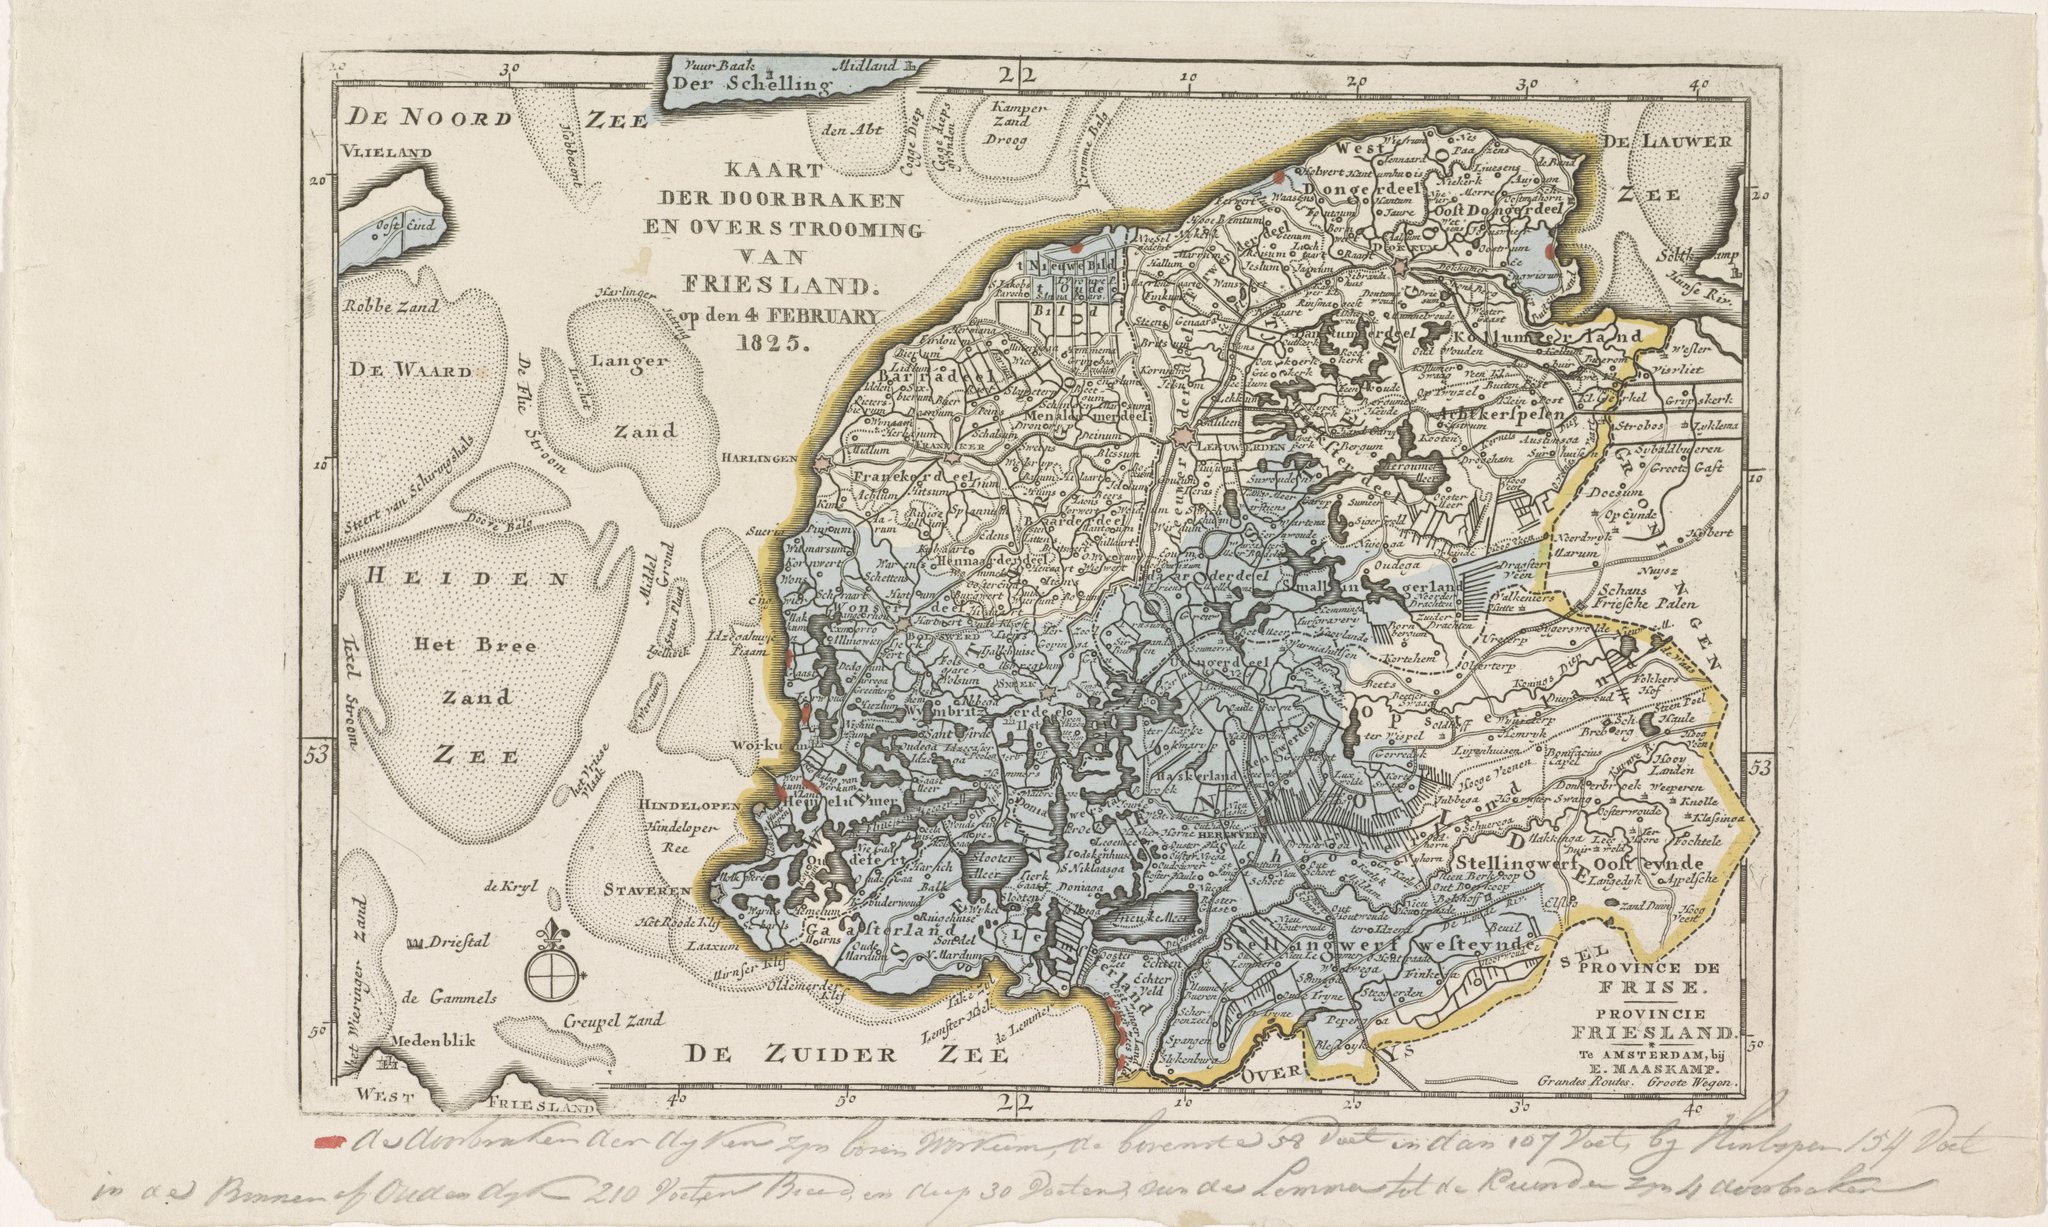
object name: print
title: Kaart van het gebied in Friesland getroffen door de overstromingen in 1825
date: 1825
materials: paper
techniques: engraving, hand coloring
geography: netherlands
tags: maps of separate countries or regions, flood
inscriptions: collector's mark: Lugt 2228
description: Kaart van de provincie Friesland, waarop in blauw is aangegeven het gebied dat is getroffen door de overstromingen in februari 1825 en met rood de plaatsen waar de dijken zijn doorgebroken. Onderaan het blad twee regels handschrift. Onderdeel van een serie van vijf kaarten van de getroffen gebieden.